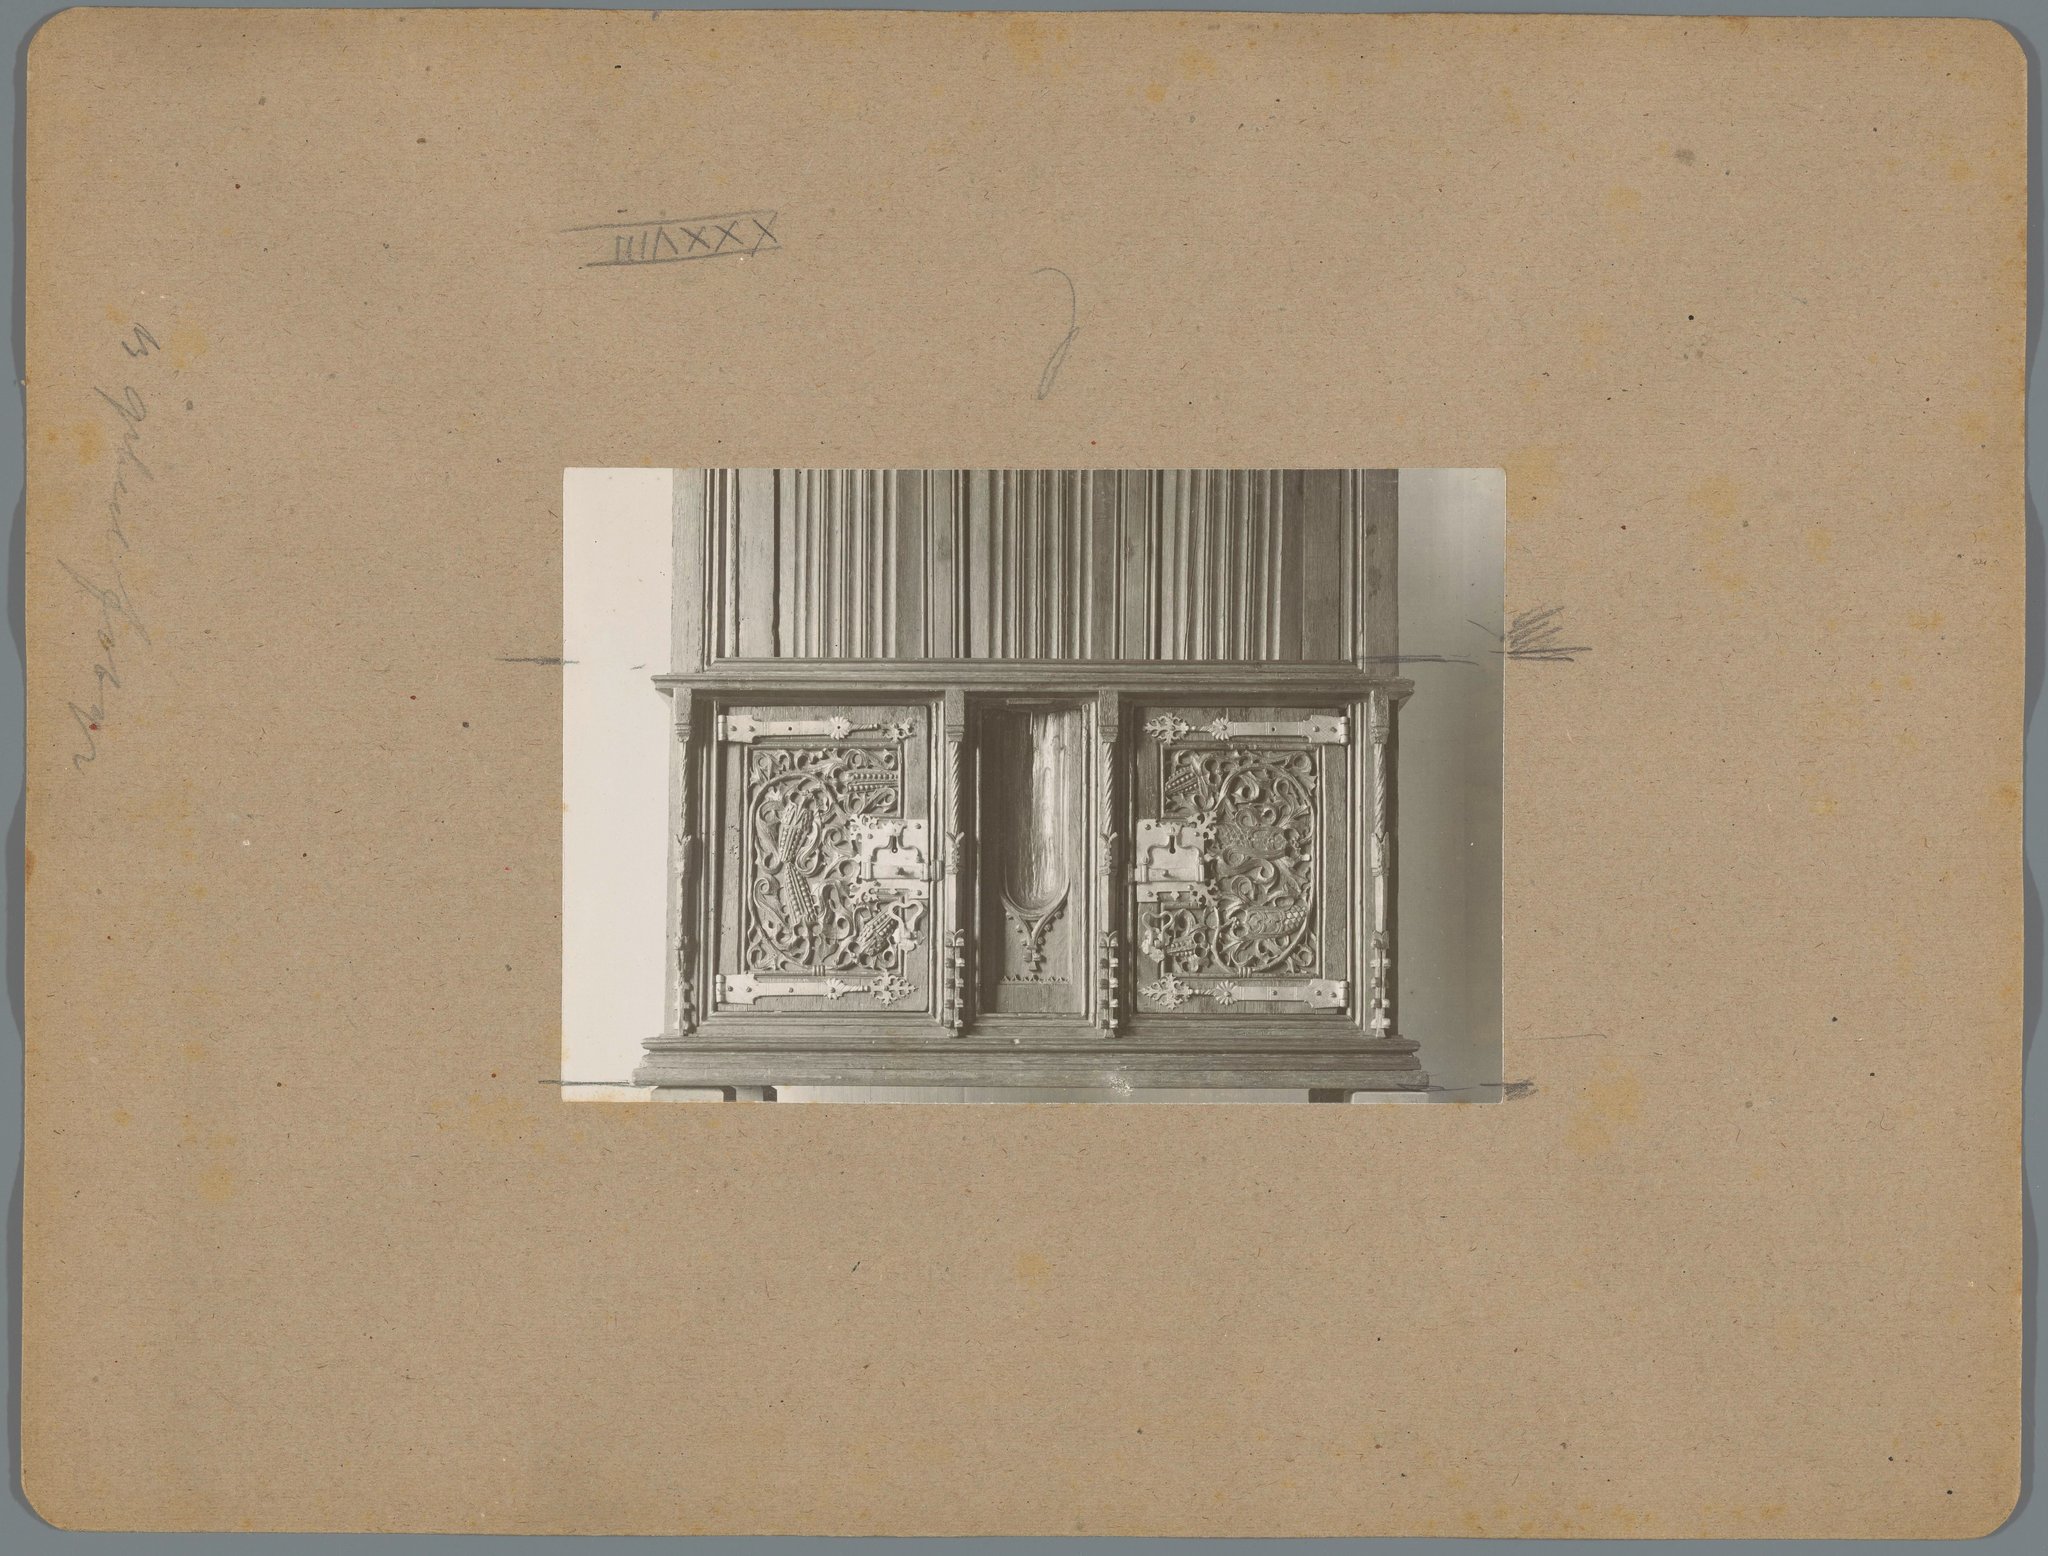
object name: photograph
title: Onderdeel van een kast geornamenteerd met een plantmotief, mogelijk mais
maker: Anonymous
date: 1875-1900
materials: cardboard, photographic support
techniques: gelatin silver print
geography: europe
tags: cupboard, ornament derived from plant forms, europe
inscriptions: collector's mark: ‘INSTITUUT VOOR KUNST-NIJVERHEIDSONDERWIJS GABRIËL METSUSTRAAT No. 16 AMSTERDAM’, number: ‘XXXVIII’, collector's mark: ‘KUNSTNIJVERHEIDSCHOOL QUELLINUS AMSTERDAM FRANS HALSSTRAAT 14.’